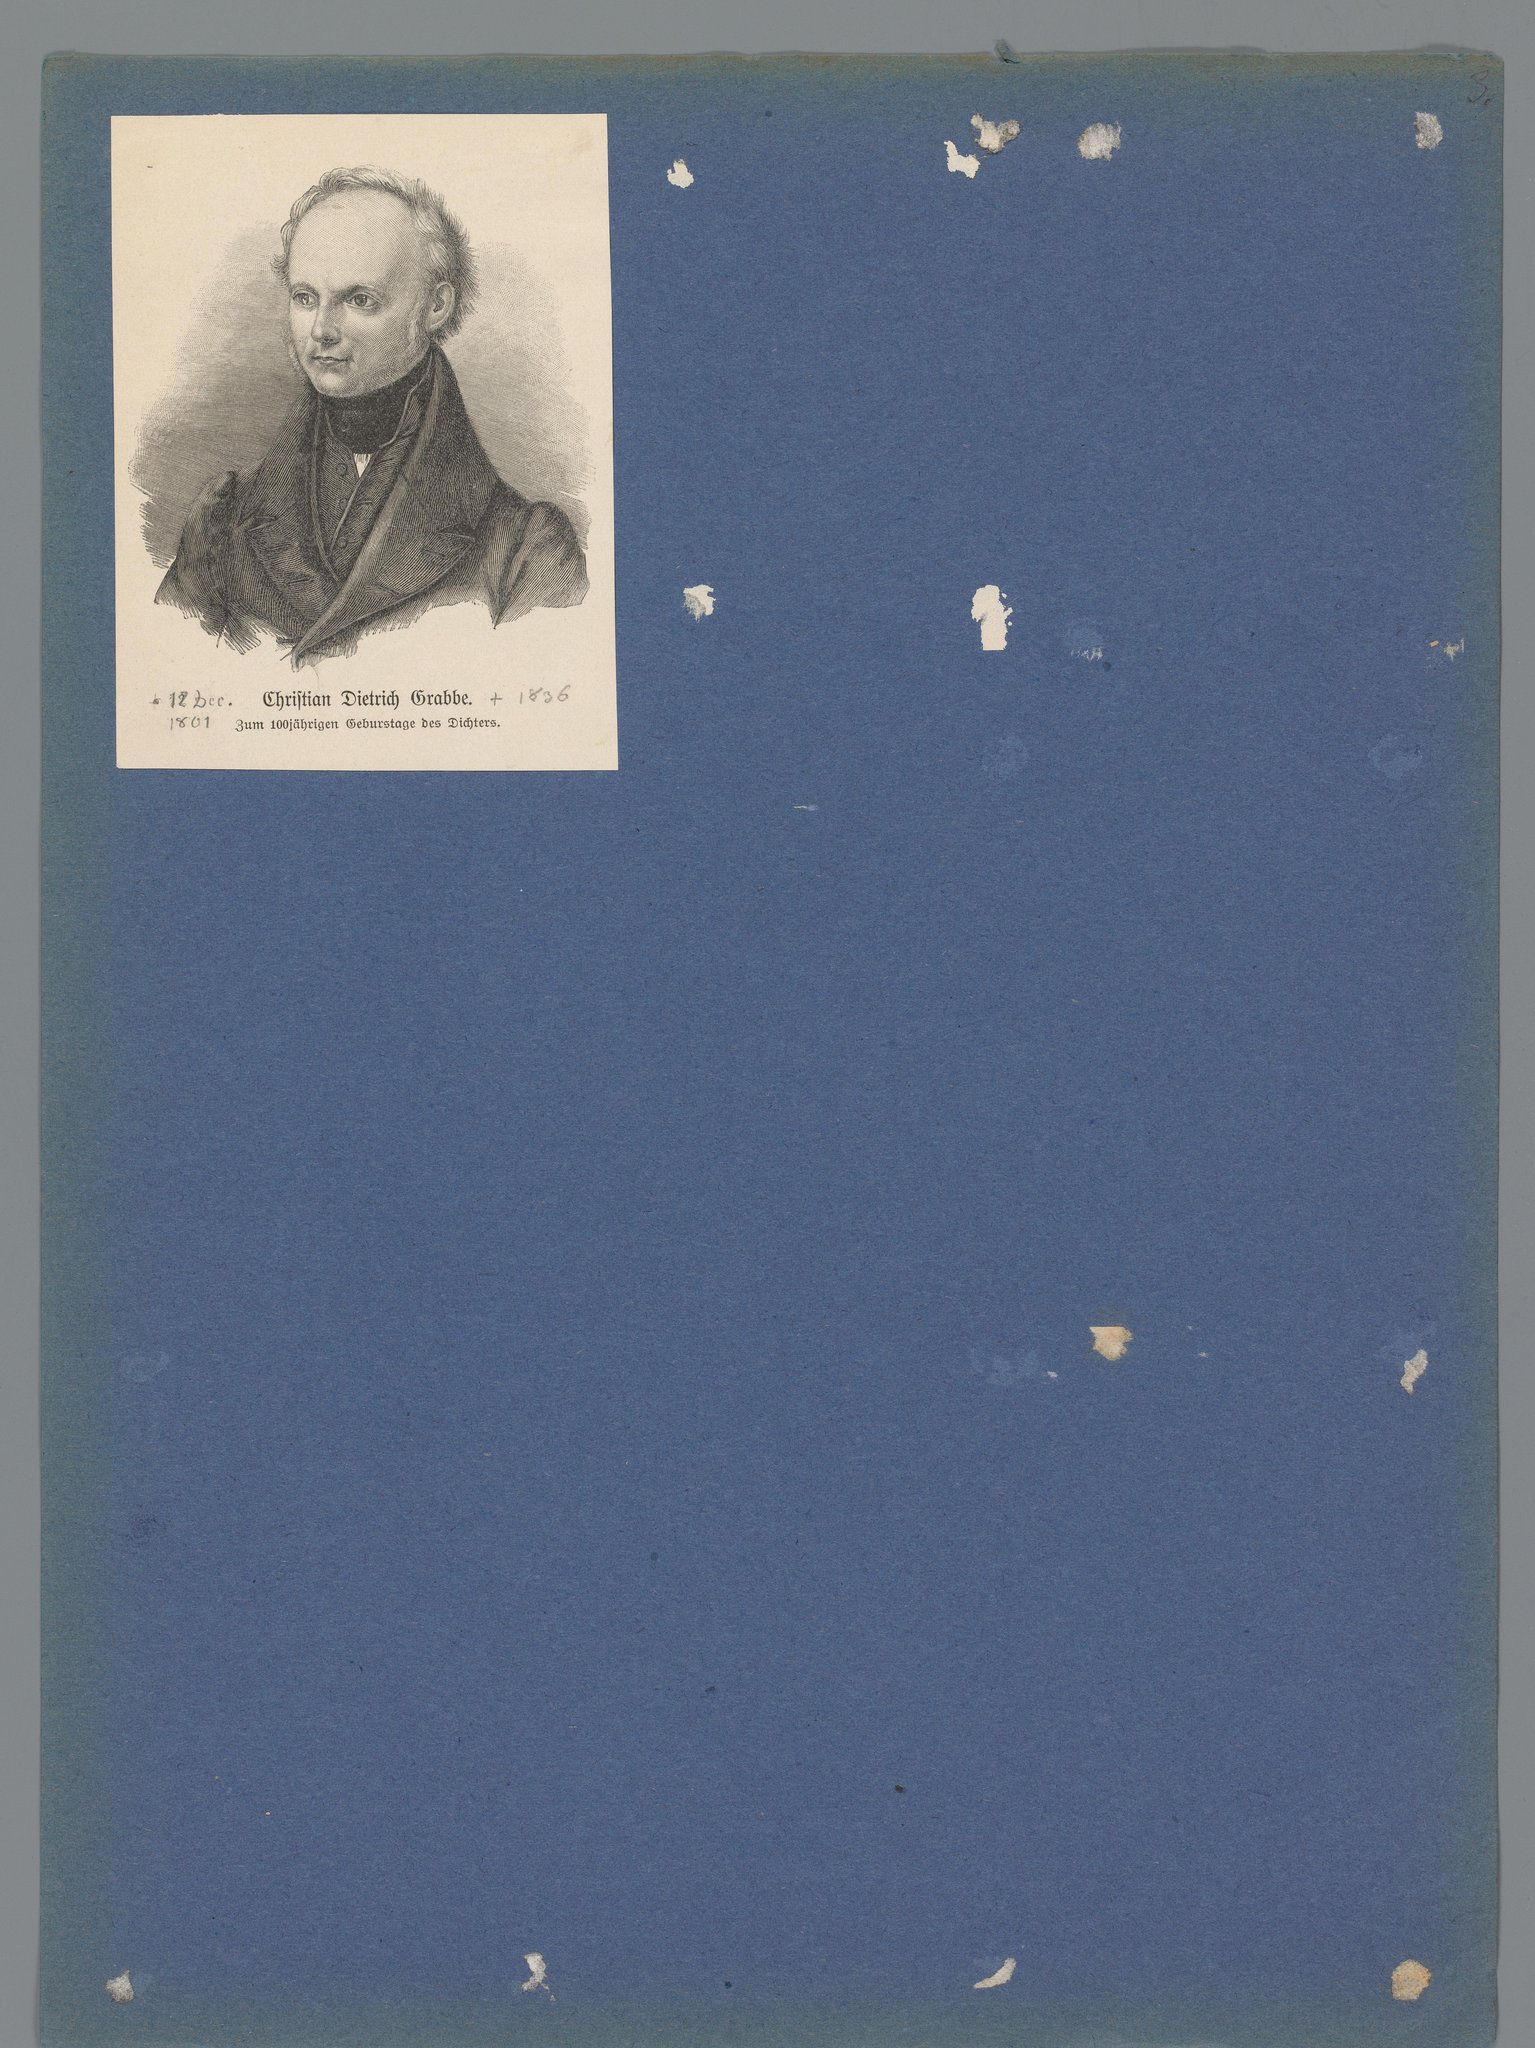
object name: sheet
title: Blad met één portret van Christian Dietrich Grabbe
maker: Anonymous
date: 1850-1900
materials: paper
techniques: snipping, engraving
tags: historical persons, portrait of a writer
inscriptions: number: ‘3’